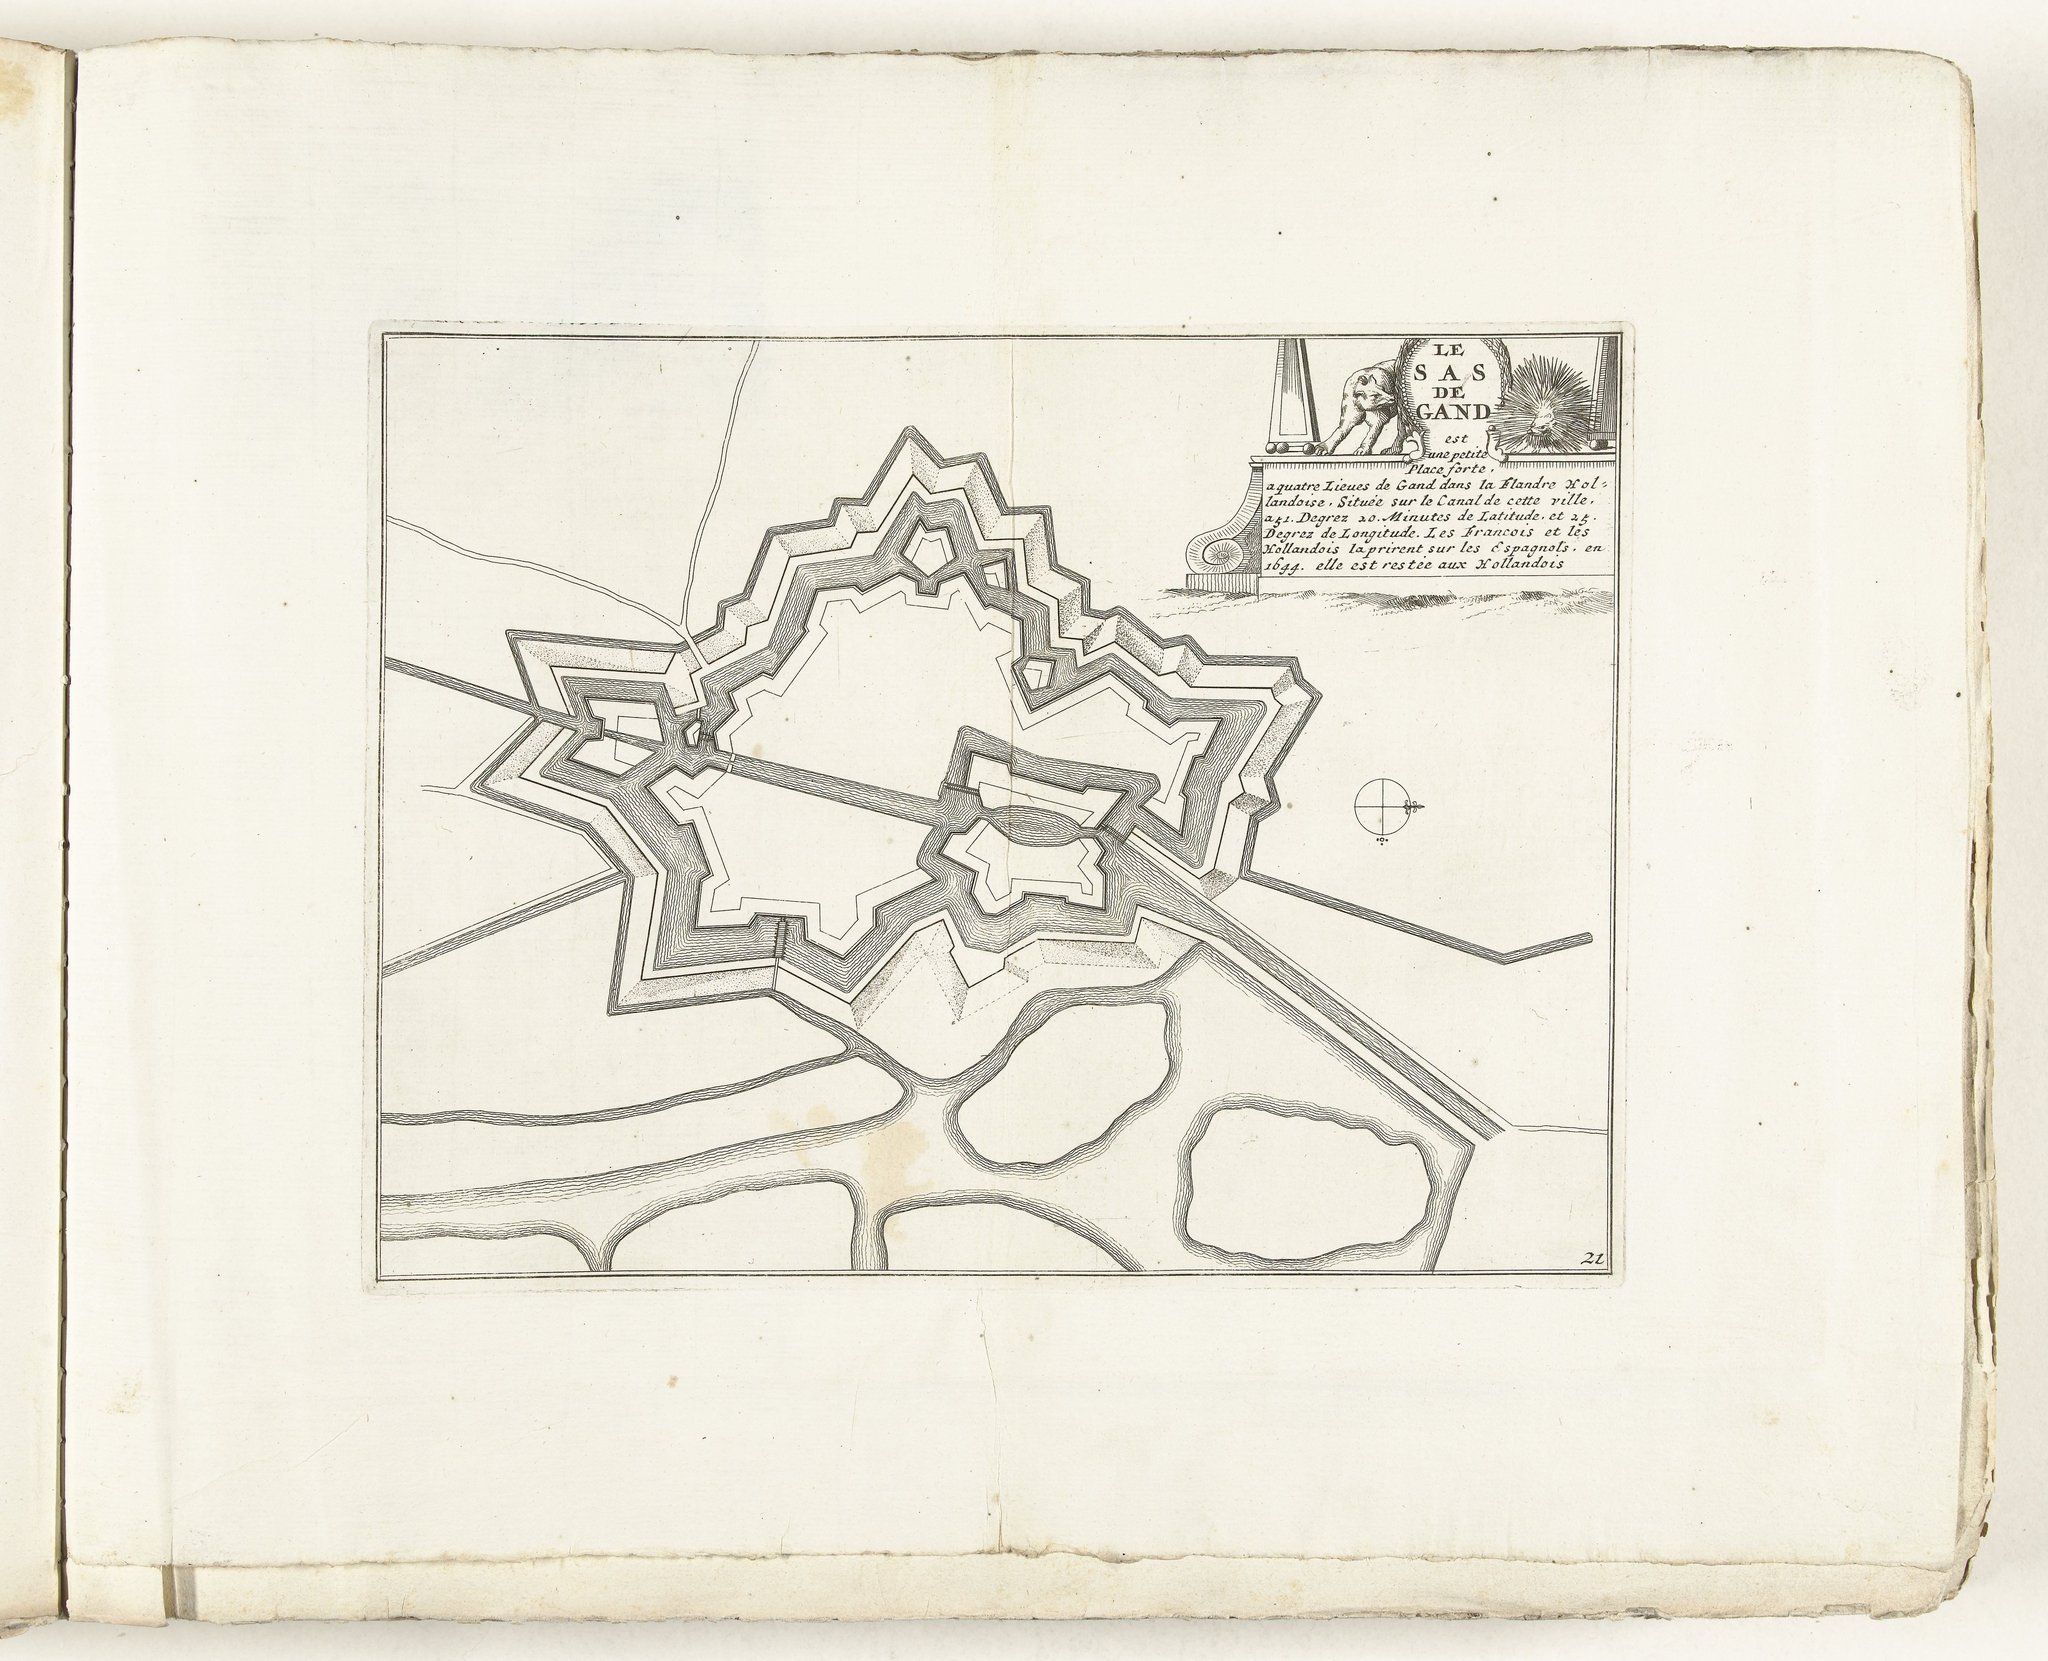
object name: print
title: Le Sas de Gand est une petite Place forte (...)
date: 1702-1703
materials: paper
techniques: etching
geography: northern netherlands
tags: fortified city, maps of cities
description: Plattegrond van de verdedigingswerken om de Vlaamse stad Sas-van-Gent. Plaat nr. 21 in het prentwerk bestaande in totaal uit 276 genummerde platen van vermaarde sterke steden en vestingen in het kader van de Spaanse Successieoorlog. Voor het merendeel zijn deze platen gekopieerd naar de anonieme Franse platen: in Les forces de l'Europe en in: Le theatre de la guerre, dans les Pays-Bas, beide oorspronkelijk uitgegeven door Nicolas de Fer te Parijs (1693-1697) in het kader van de Negenjarige Oorlog. Titel en opschriften in het Frans.